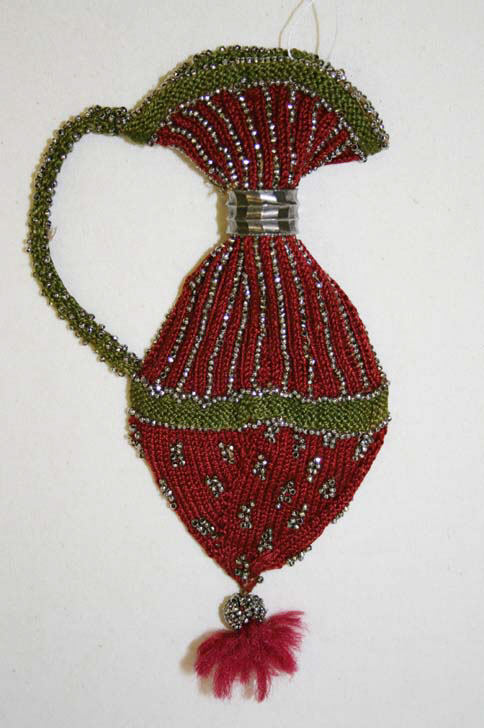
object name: purse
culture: european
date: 1834-1866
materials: metal, silk